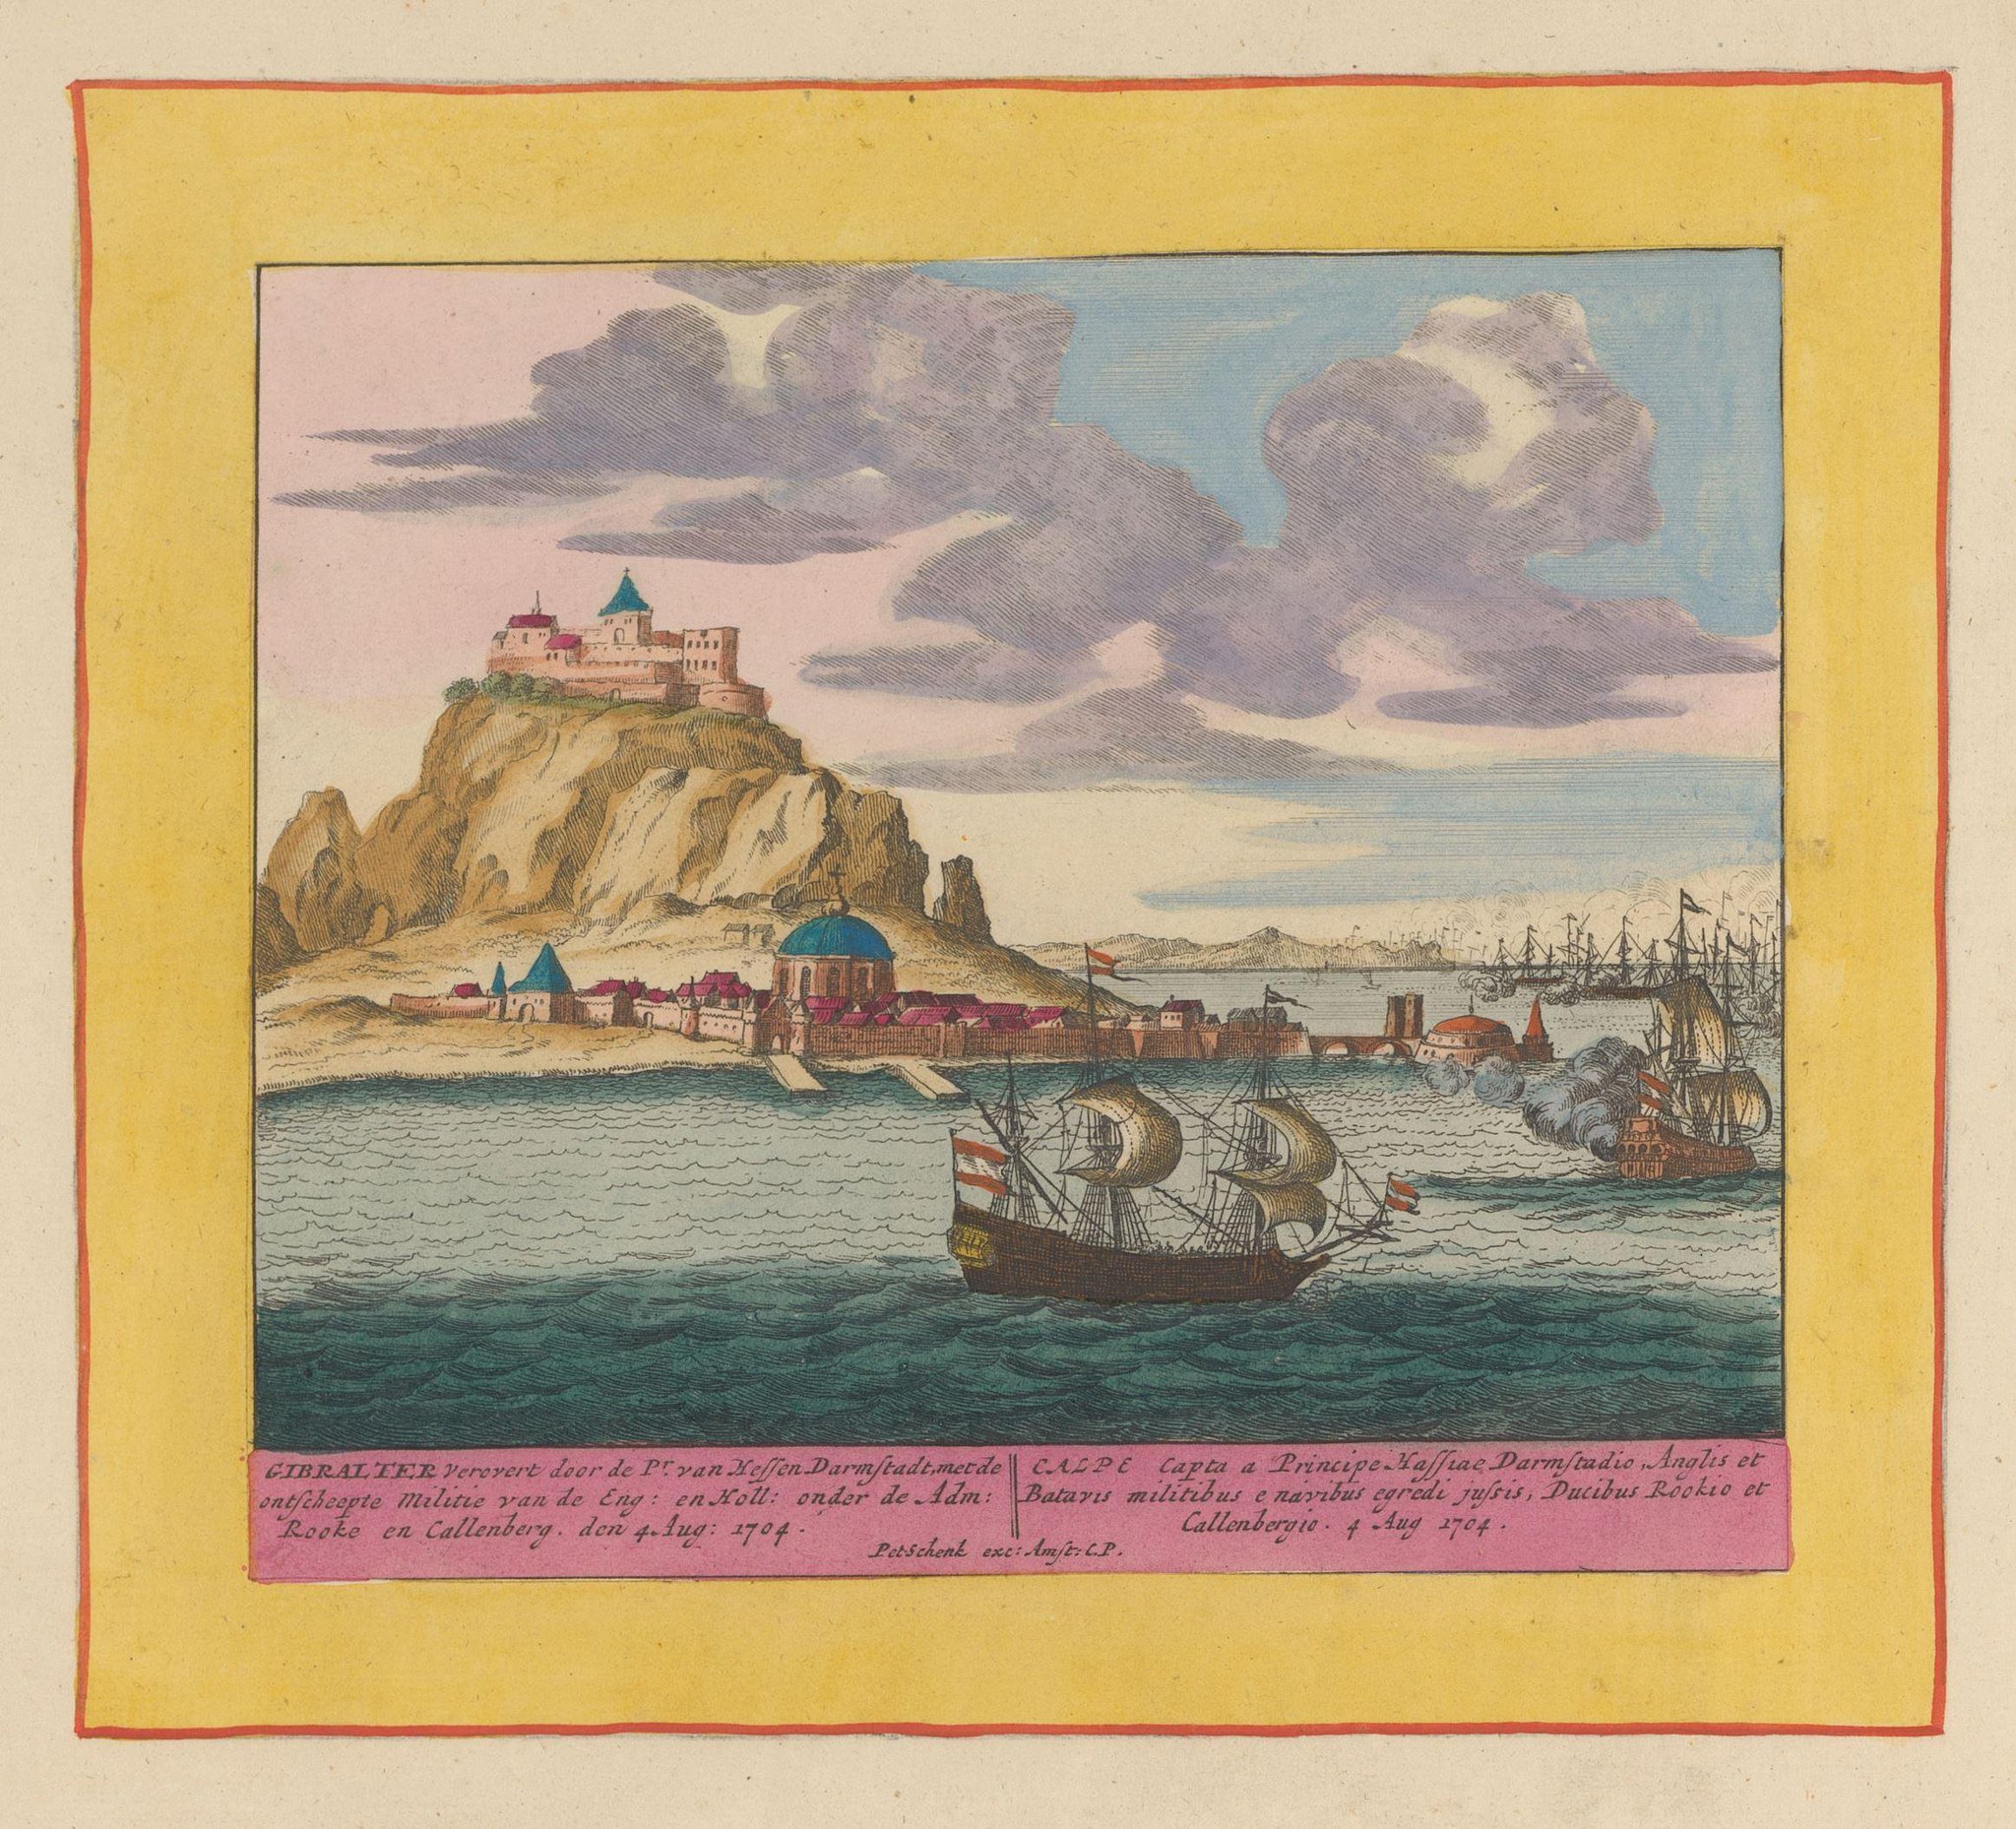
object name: album leaf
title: Verovering van Gibraltar door een Engels-Nederlandse vloot, 1704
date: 1707-1720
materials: paper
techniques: etching, hand coloring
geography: the hague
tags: battle (+ naval force)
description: Prent uit: Schouwburg van den oorlog, beginnende van Karel den II. tot op koning Karel den III. : bestaande in IX historische figuren op een olifants blad, als veldslagen, belegeringen te water en te lande, met de voornaamste vestingen. Amsterdam: Pieter Schenk, 1709.